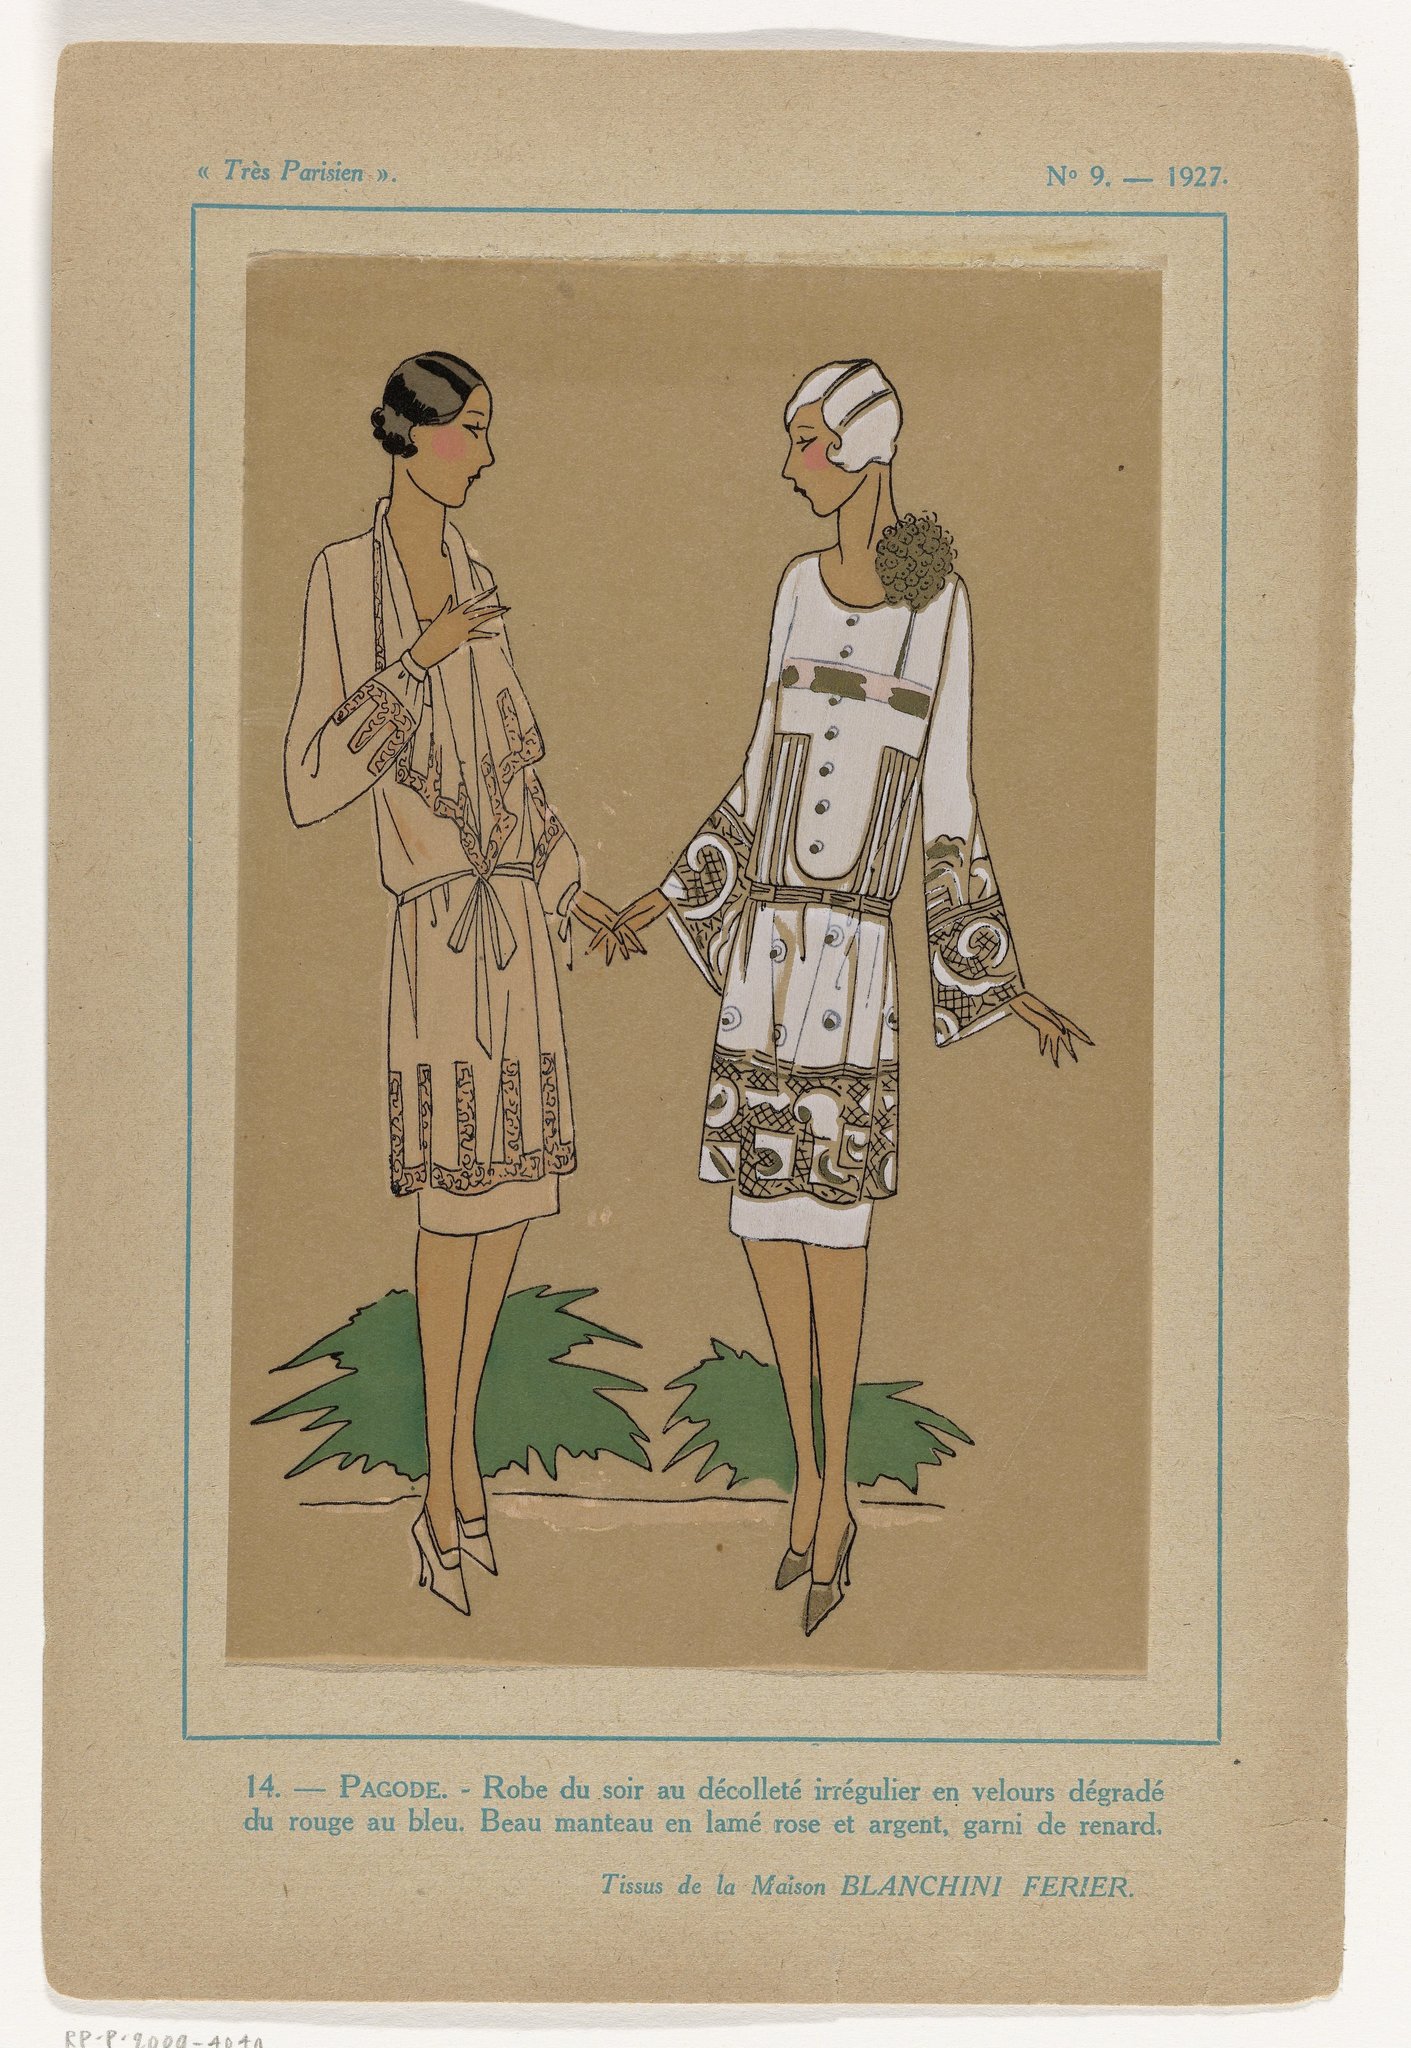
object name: fashion print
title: Très Parisien, 1927, No. 9 : 14.- PAGODE.- Robe du soir (...)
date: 1927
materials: paper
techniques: hand coloring, letterpress printing, lithography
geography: paris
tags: corsage (+ women's clothes), fashion plates, dress, gown (+ women's clothes)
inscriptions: caption: ‘14. - PAGODE. - Robe du soir au décolleté irrégulier en velours dégradé du rouge au bleu. Beau manteau en lamé rose et argent, garni de renard. / Tissus de la Maison BLANCHINI FERIER.’, title: ‘"Très Parisien" / No 9. - 1927.’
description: Volgens het onderschrift is dit een avondjurk van fluweel met een overloop(?) van rood naar blauw. 'Manteau' (jasjurk?) van roze- en zilverkleurige lamé, gegarneerd met vossenbont. Stoffen van Maison Blanchini Ferier. Prent uit het modetijdschrift Très Parisien (1920-1936).